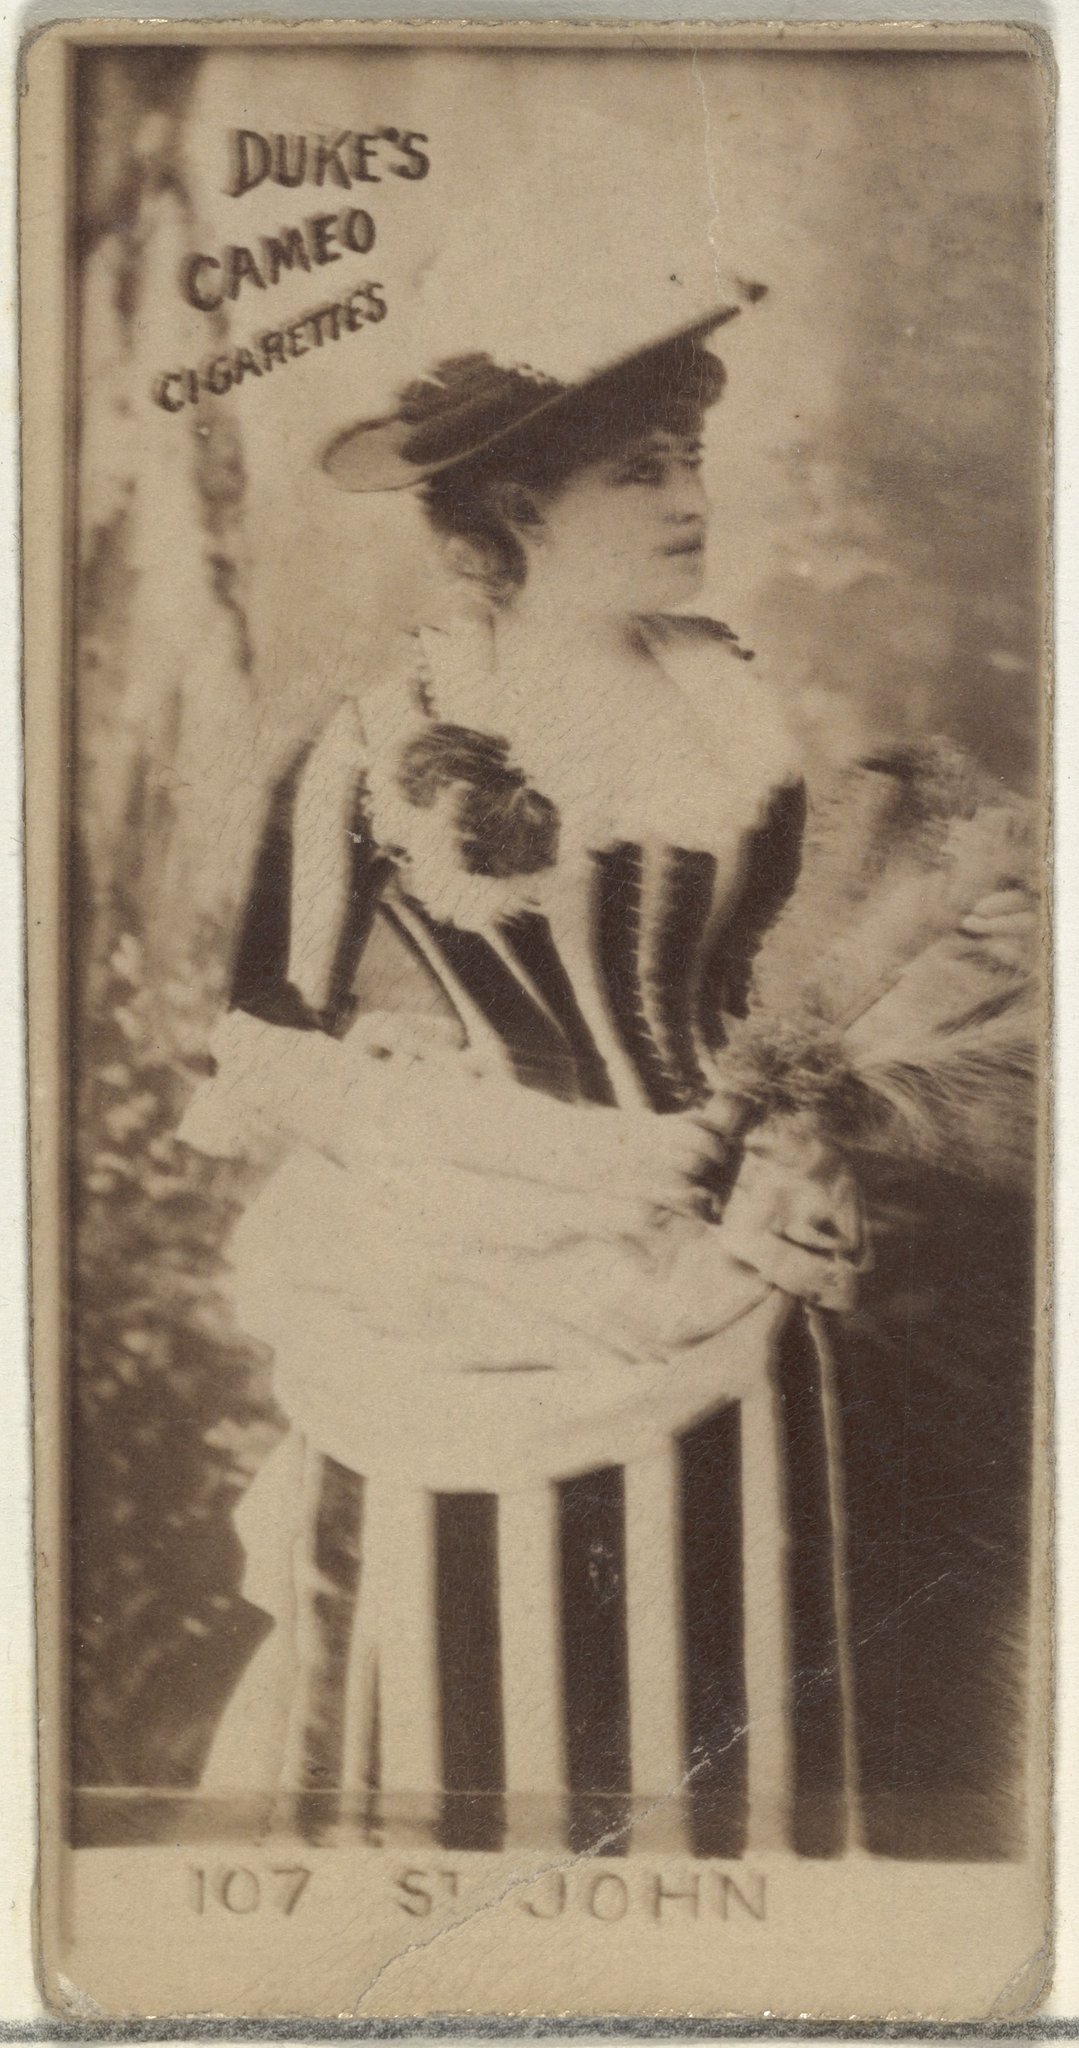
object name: photograph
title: Card Number 107, Marie St. John, from the Actors and Actresses series (N145-4) issued by Duke Sons & Co. to promote Cameo Cigarettes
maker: w. duke, sons & co.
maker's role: publisher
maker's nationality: american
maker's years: 1870-1920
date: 1880-1889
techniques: albumen silver print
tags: portraits,women,actresses